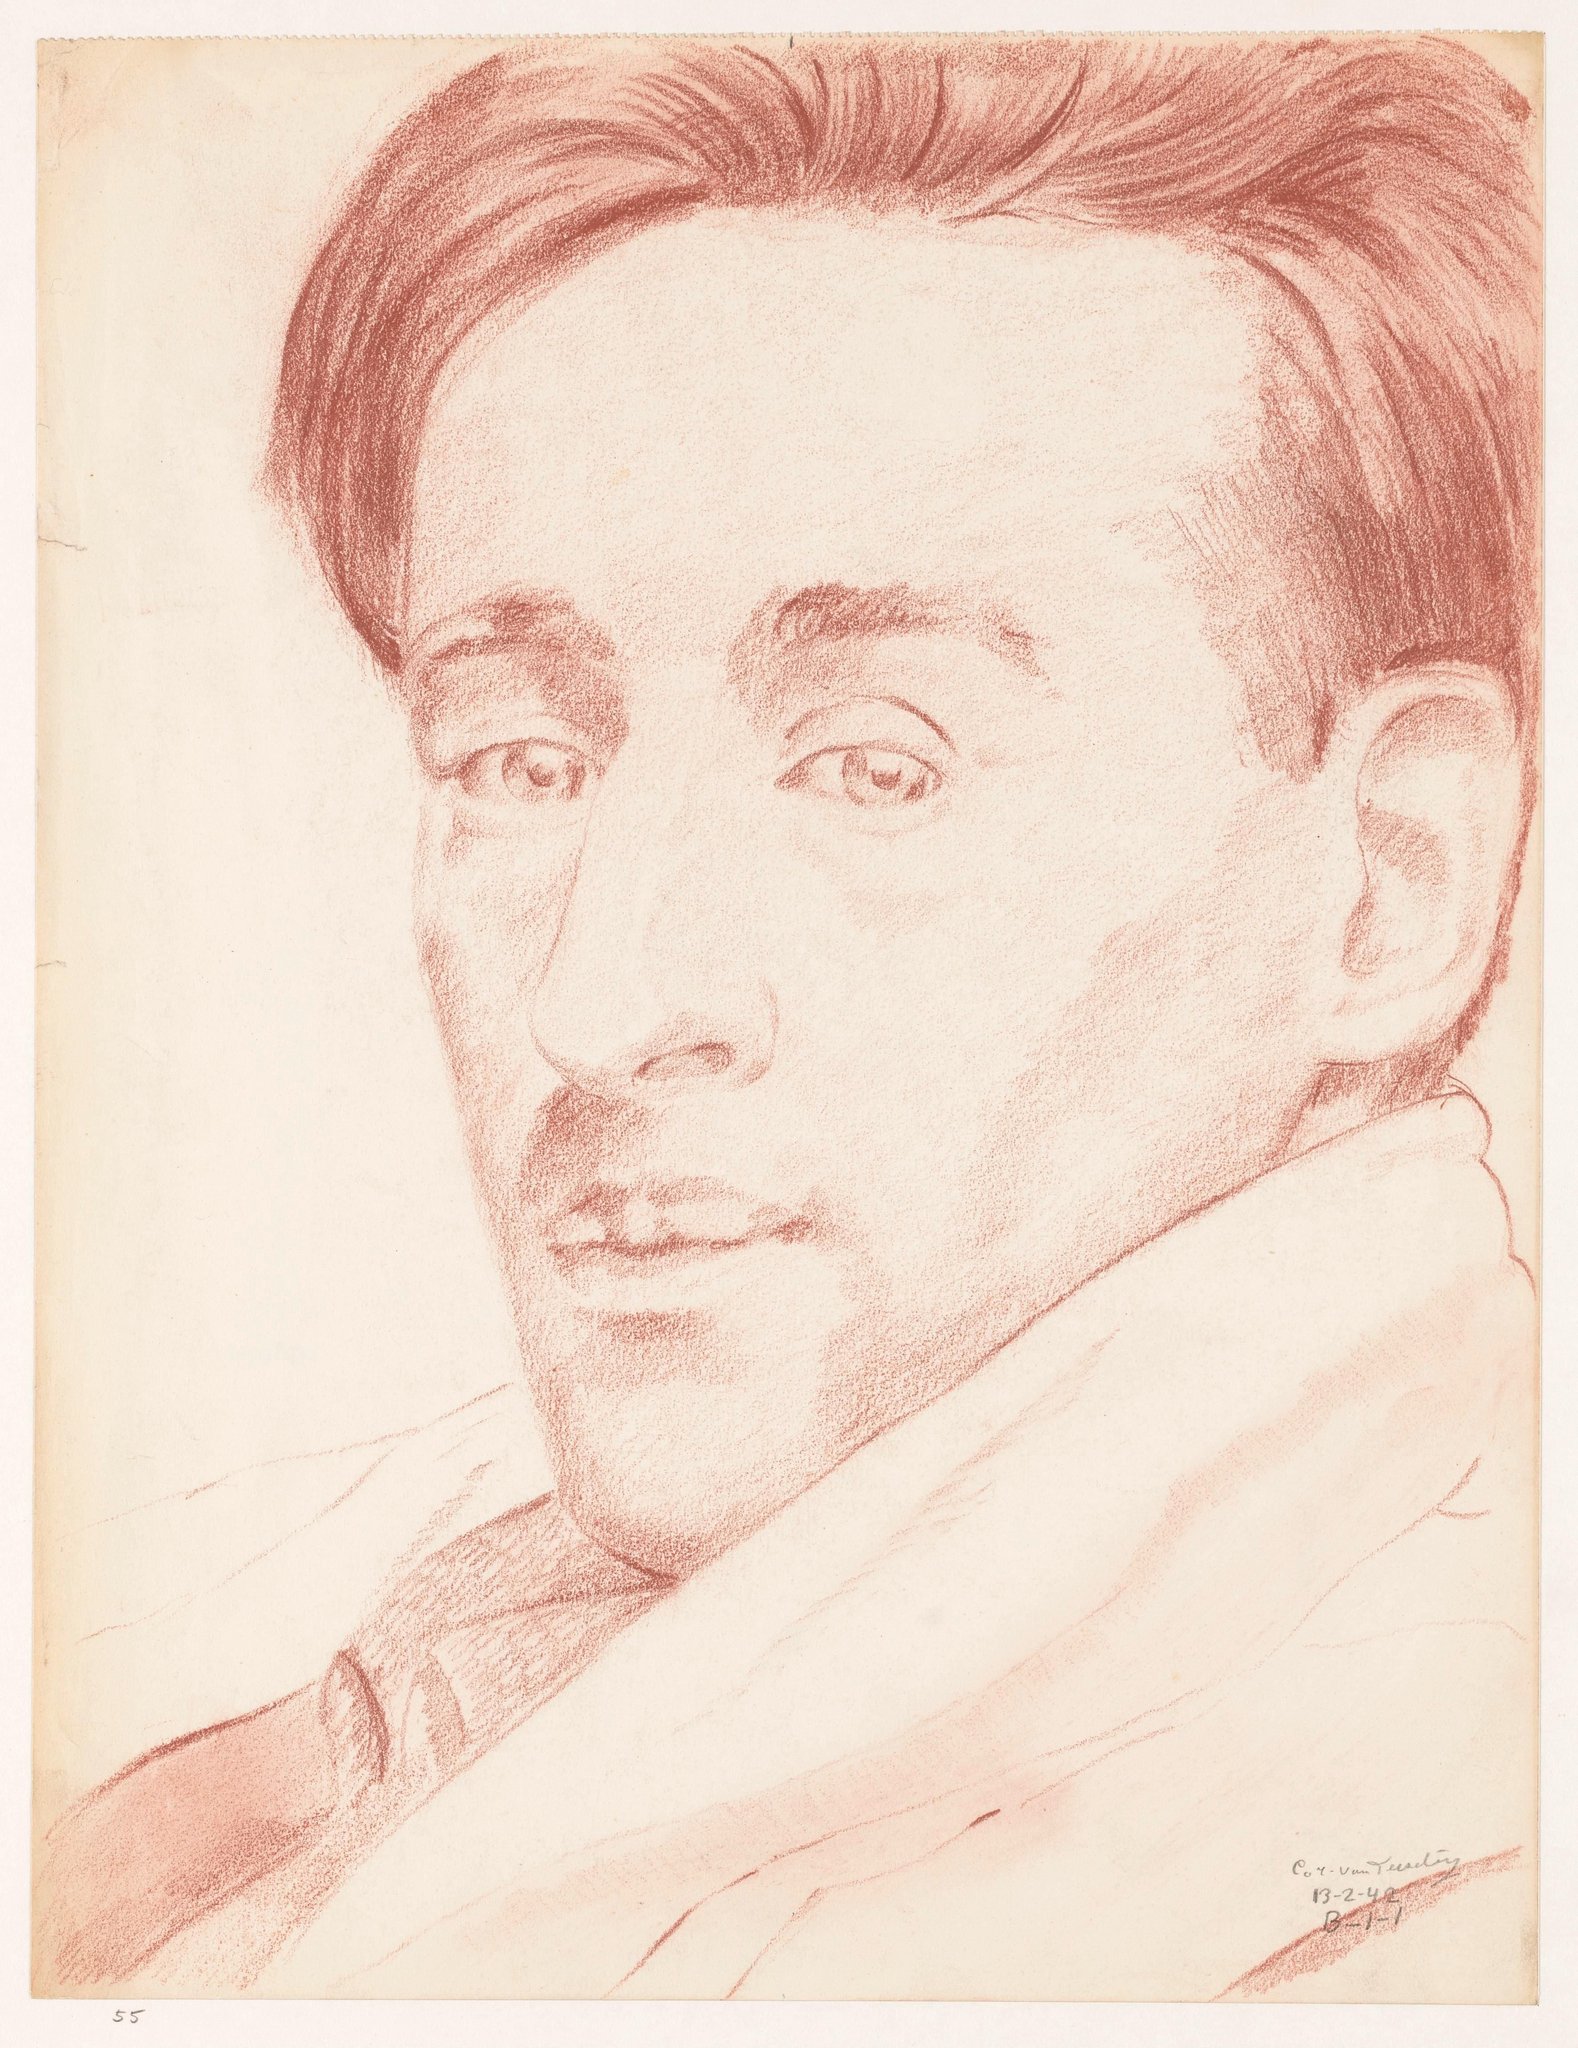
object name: drawing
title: Zelfportretten van Cor van Teeseling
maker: cor van teeseling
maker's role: draughtsman, sculptor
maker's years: 1915-1942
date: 1942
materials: chalk, paper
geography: weteringschans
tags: amsterdam, draughtsman, sculptor, cor van teeseling, historical persons, prisoner in cell or locked place, portrait, self-portrait of draughtsman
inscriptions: date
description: Zelfportret van Cor van Teeseling: B-1-1, 13 februari. Getekend zelfportret van Cor van Teeseling driekwart, naar links kijkend, waarbij de boven- en achterkant van het hoofd zijn weggelaten.